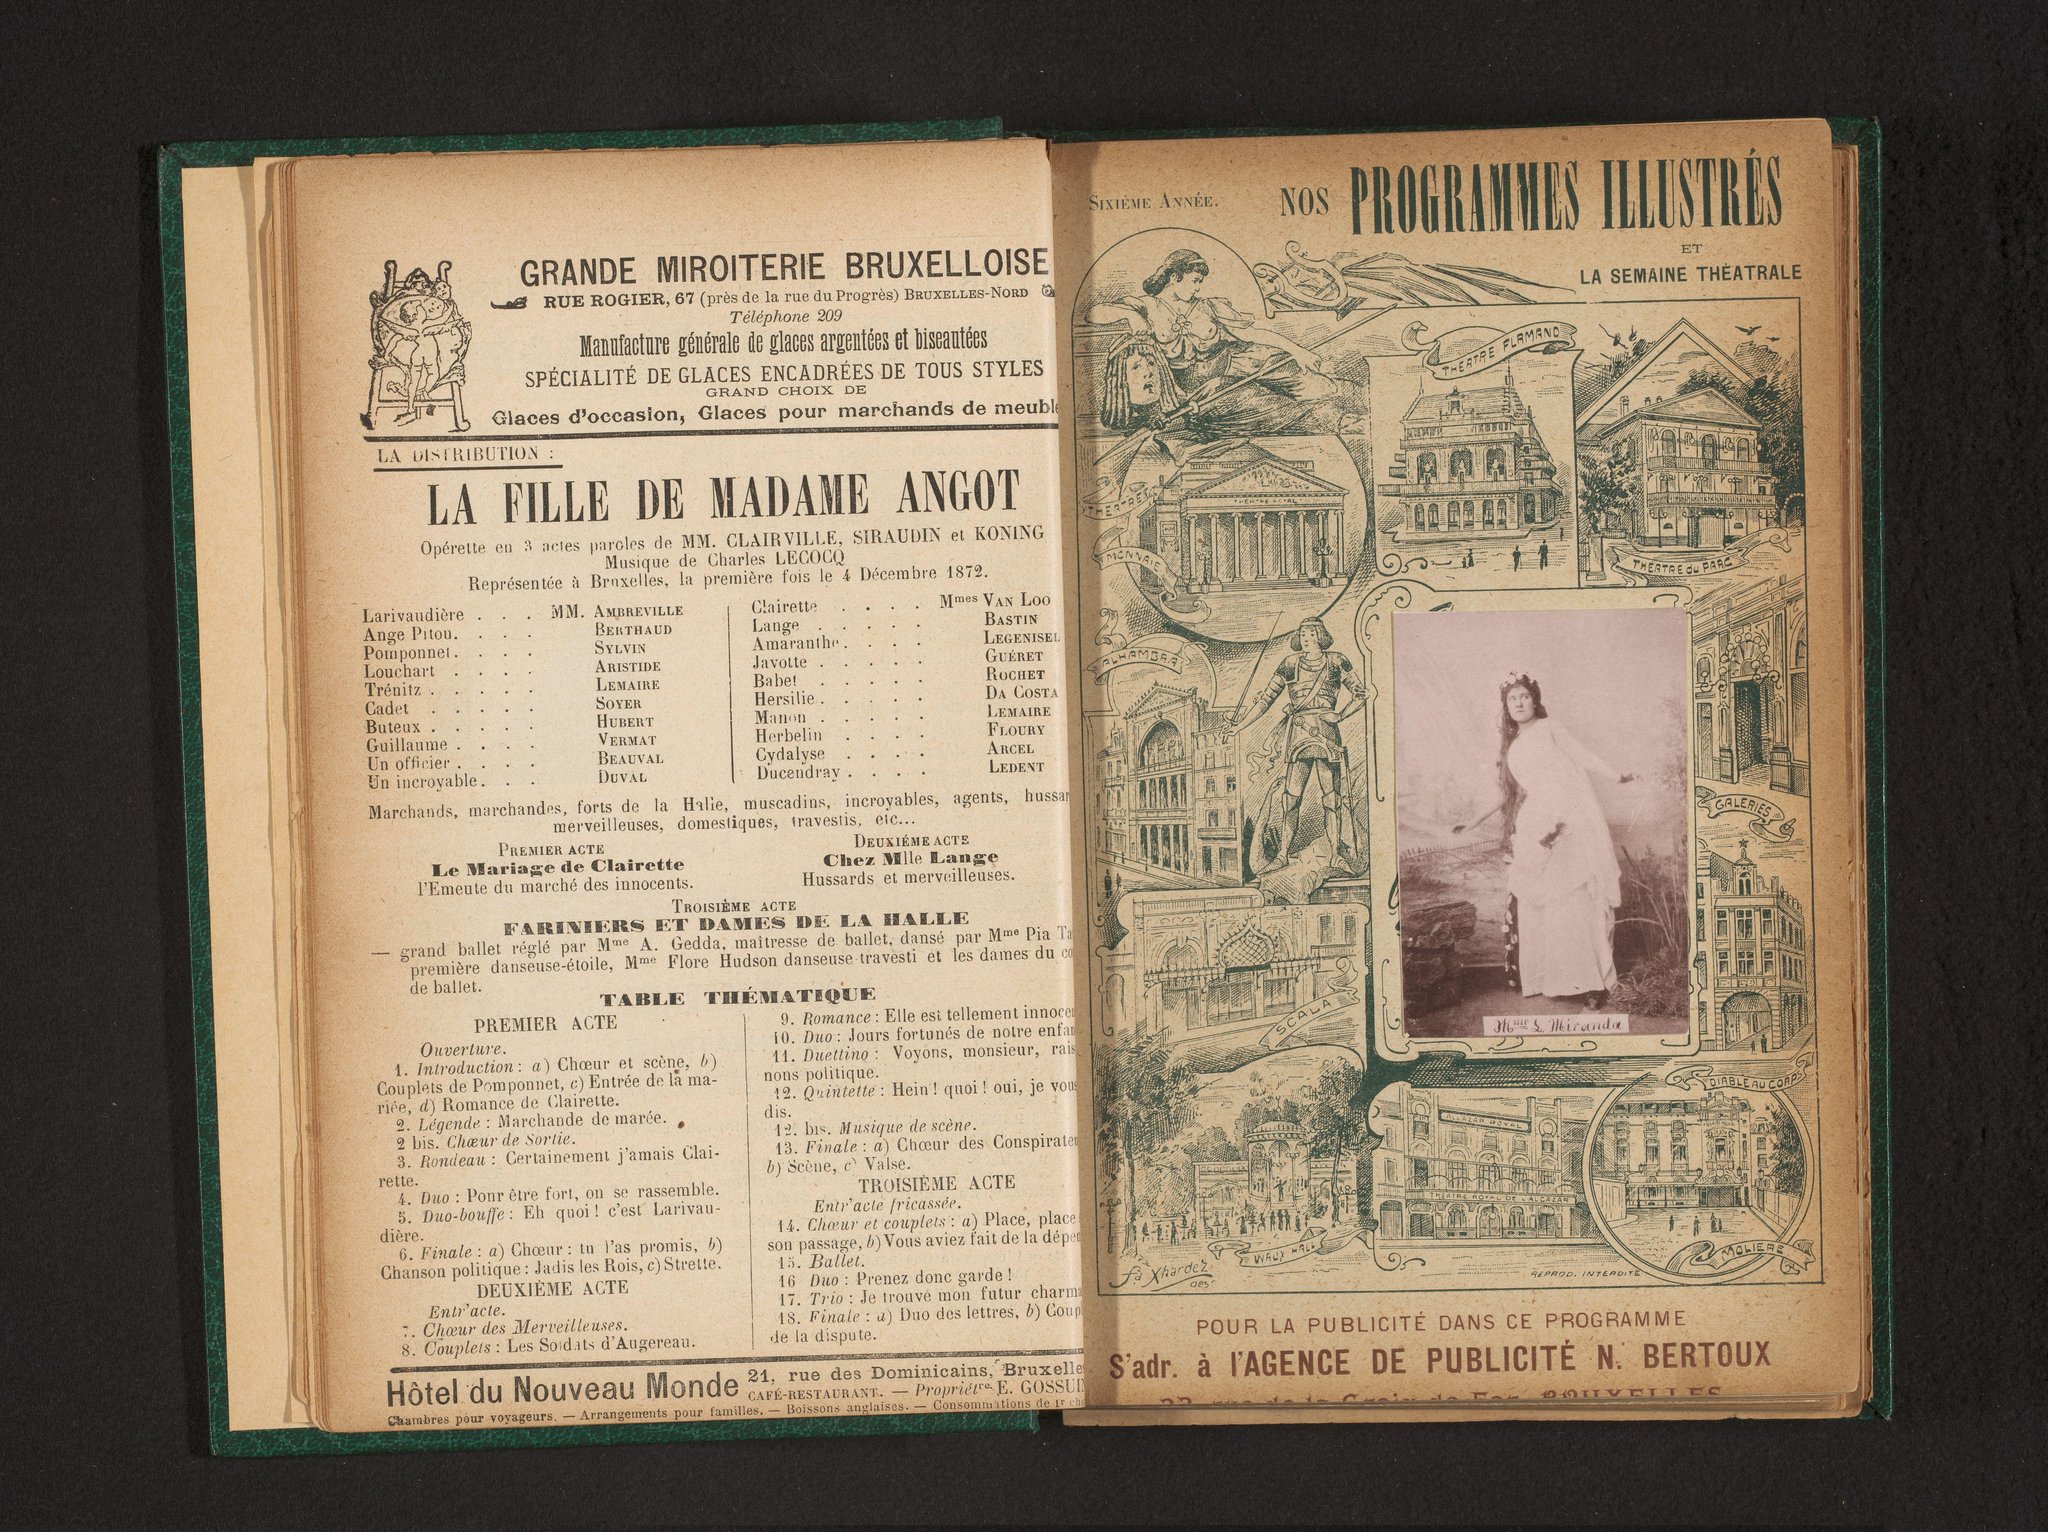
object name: page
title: Portret van Miranda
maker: Anonymous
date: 1895-1900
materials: paper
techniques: photograph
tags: adult woman, historical persons